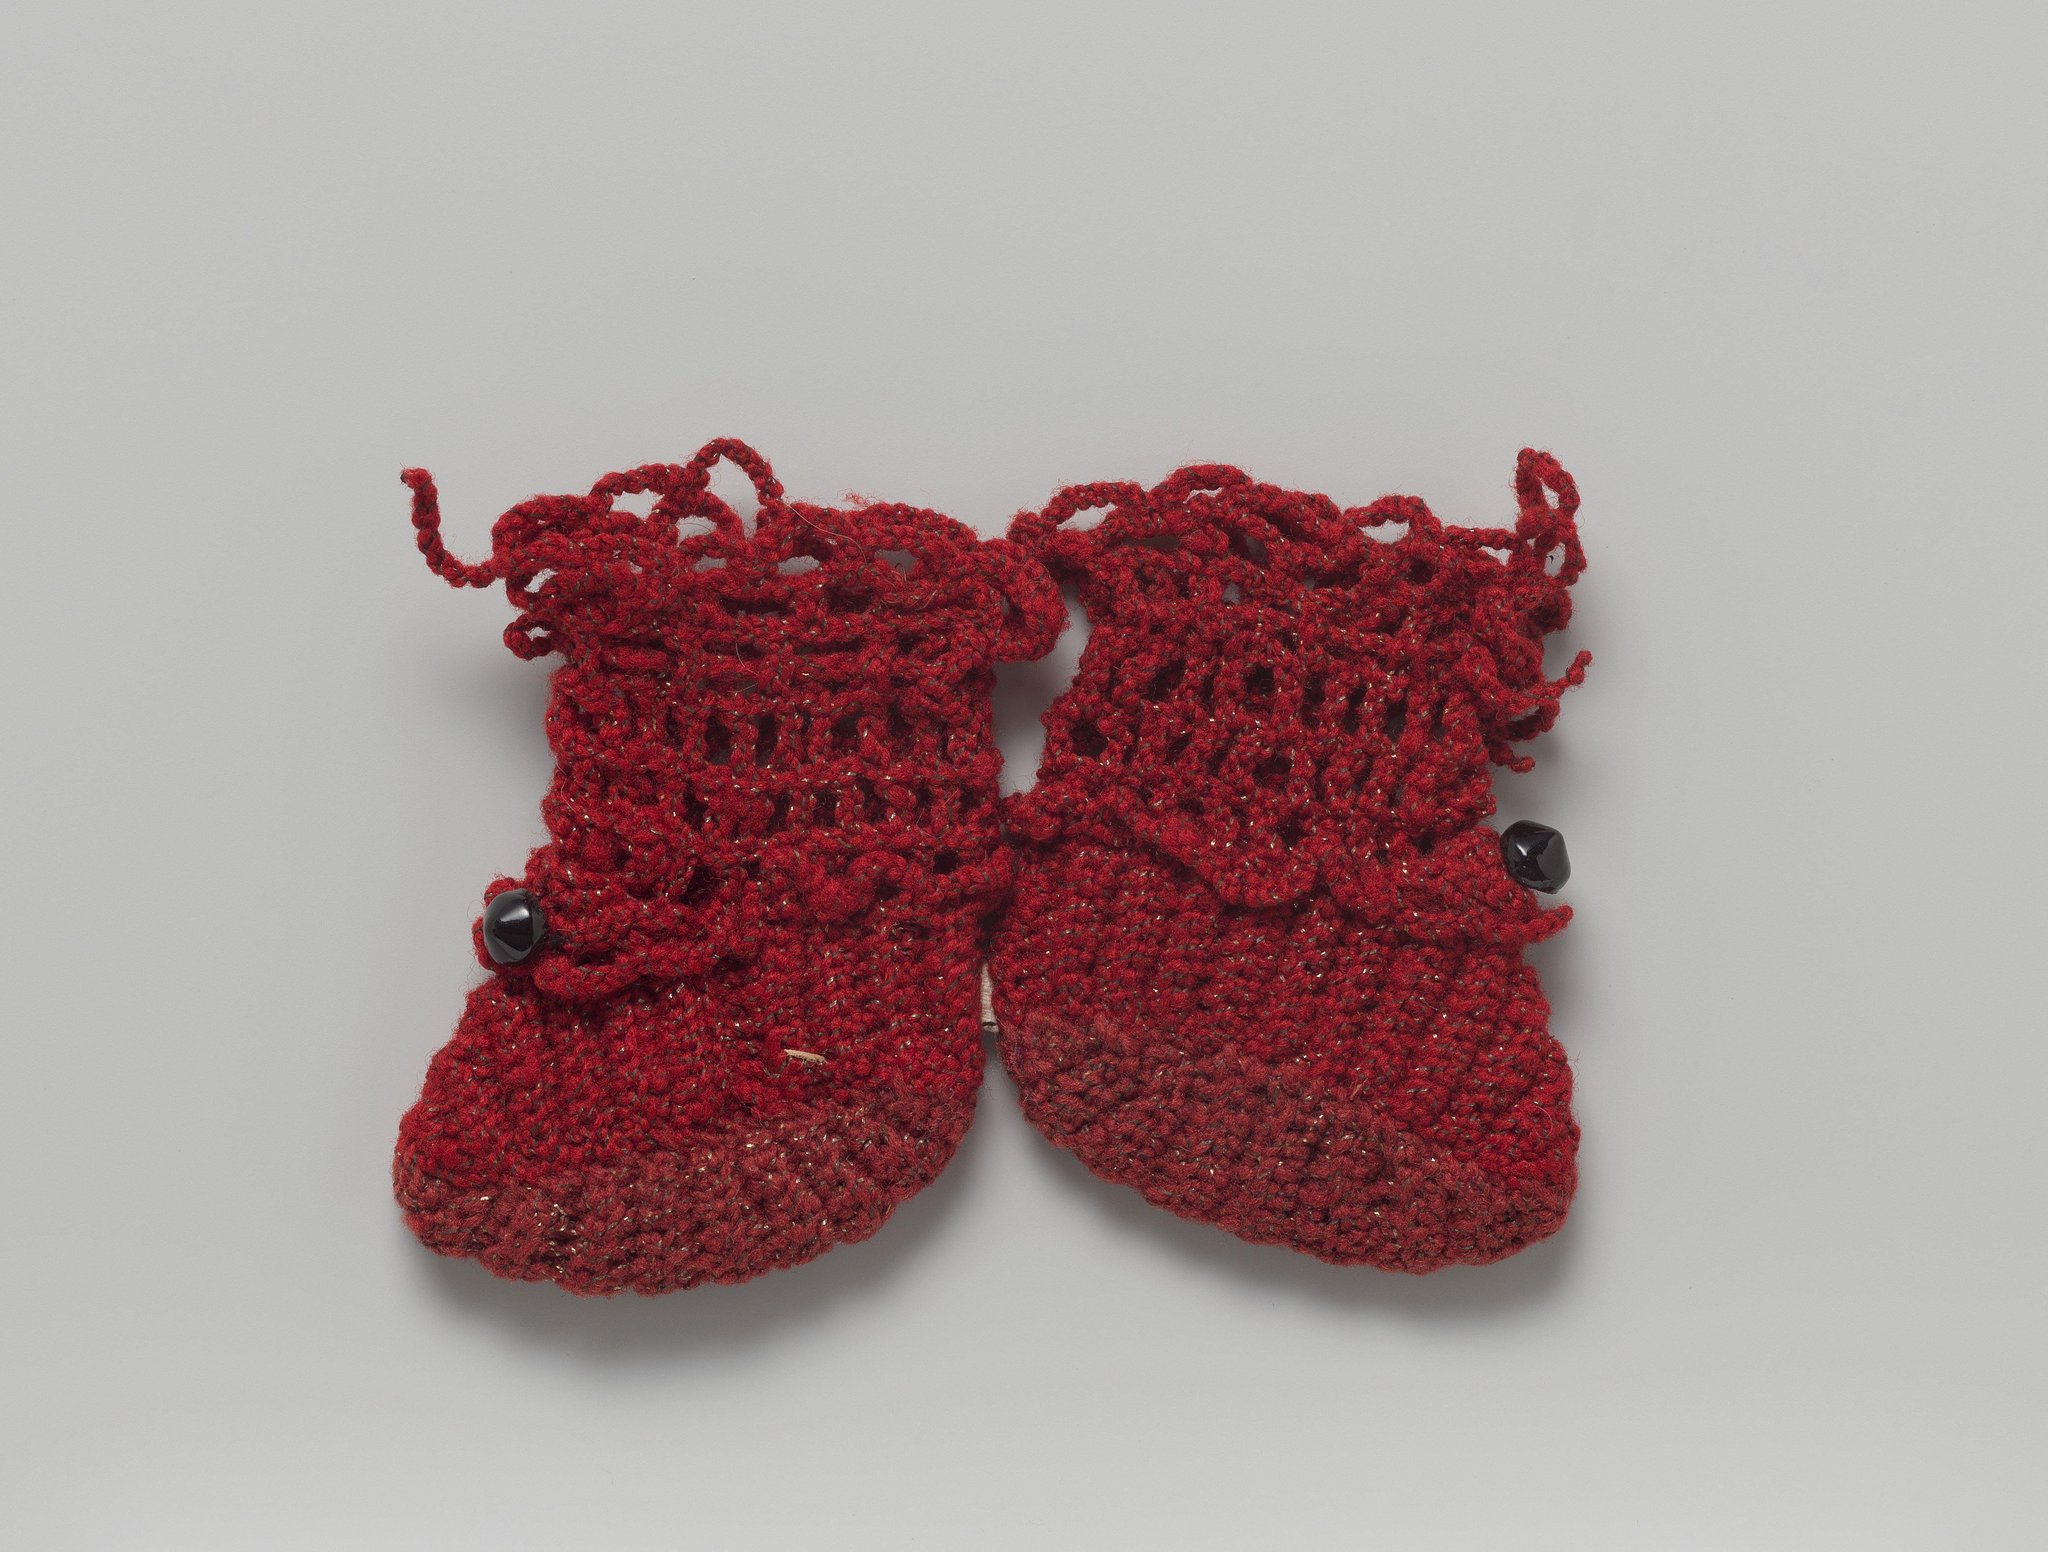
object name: sock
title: Paar rode sokken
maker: Anonymous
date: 1850-1920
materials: metal, textile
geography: netherlands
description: De sokken hebben op de wreef een zwarte glanzende knoop en zijn met een label aaneen genaaid.